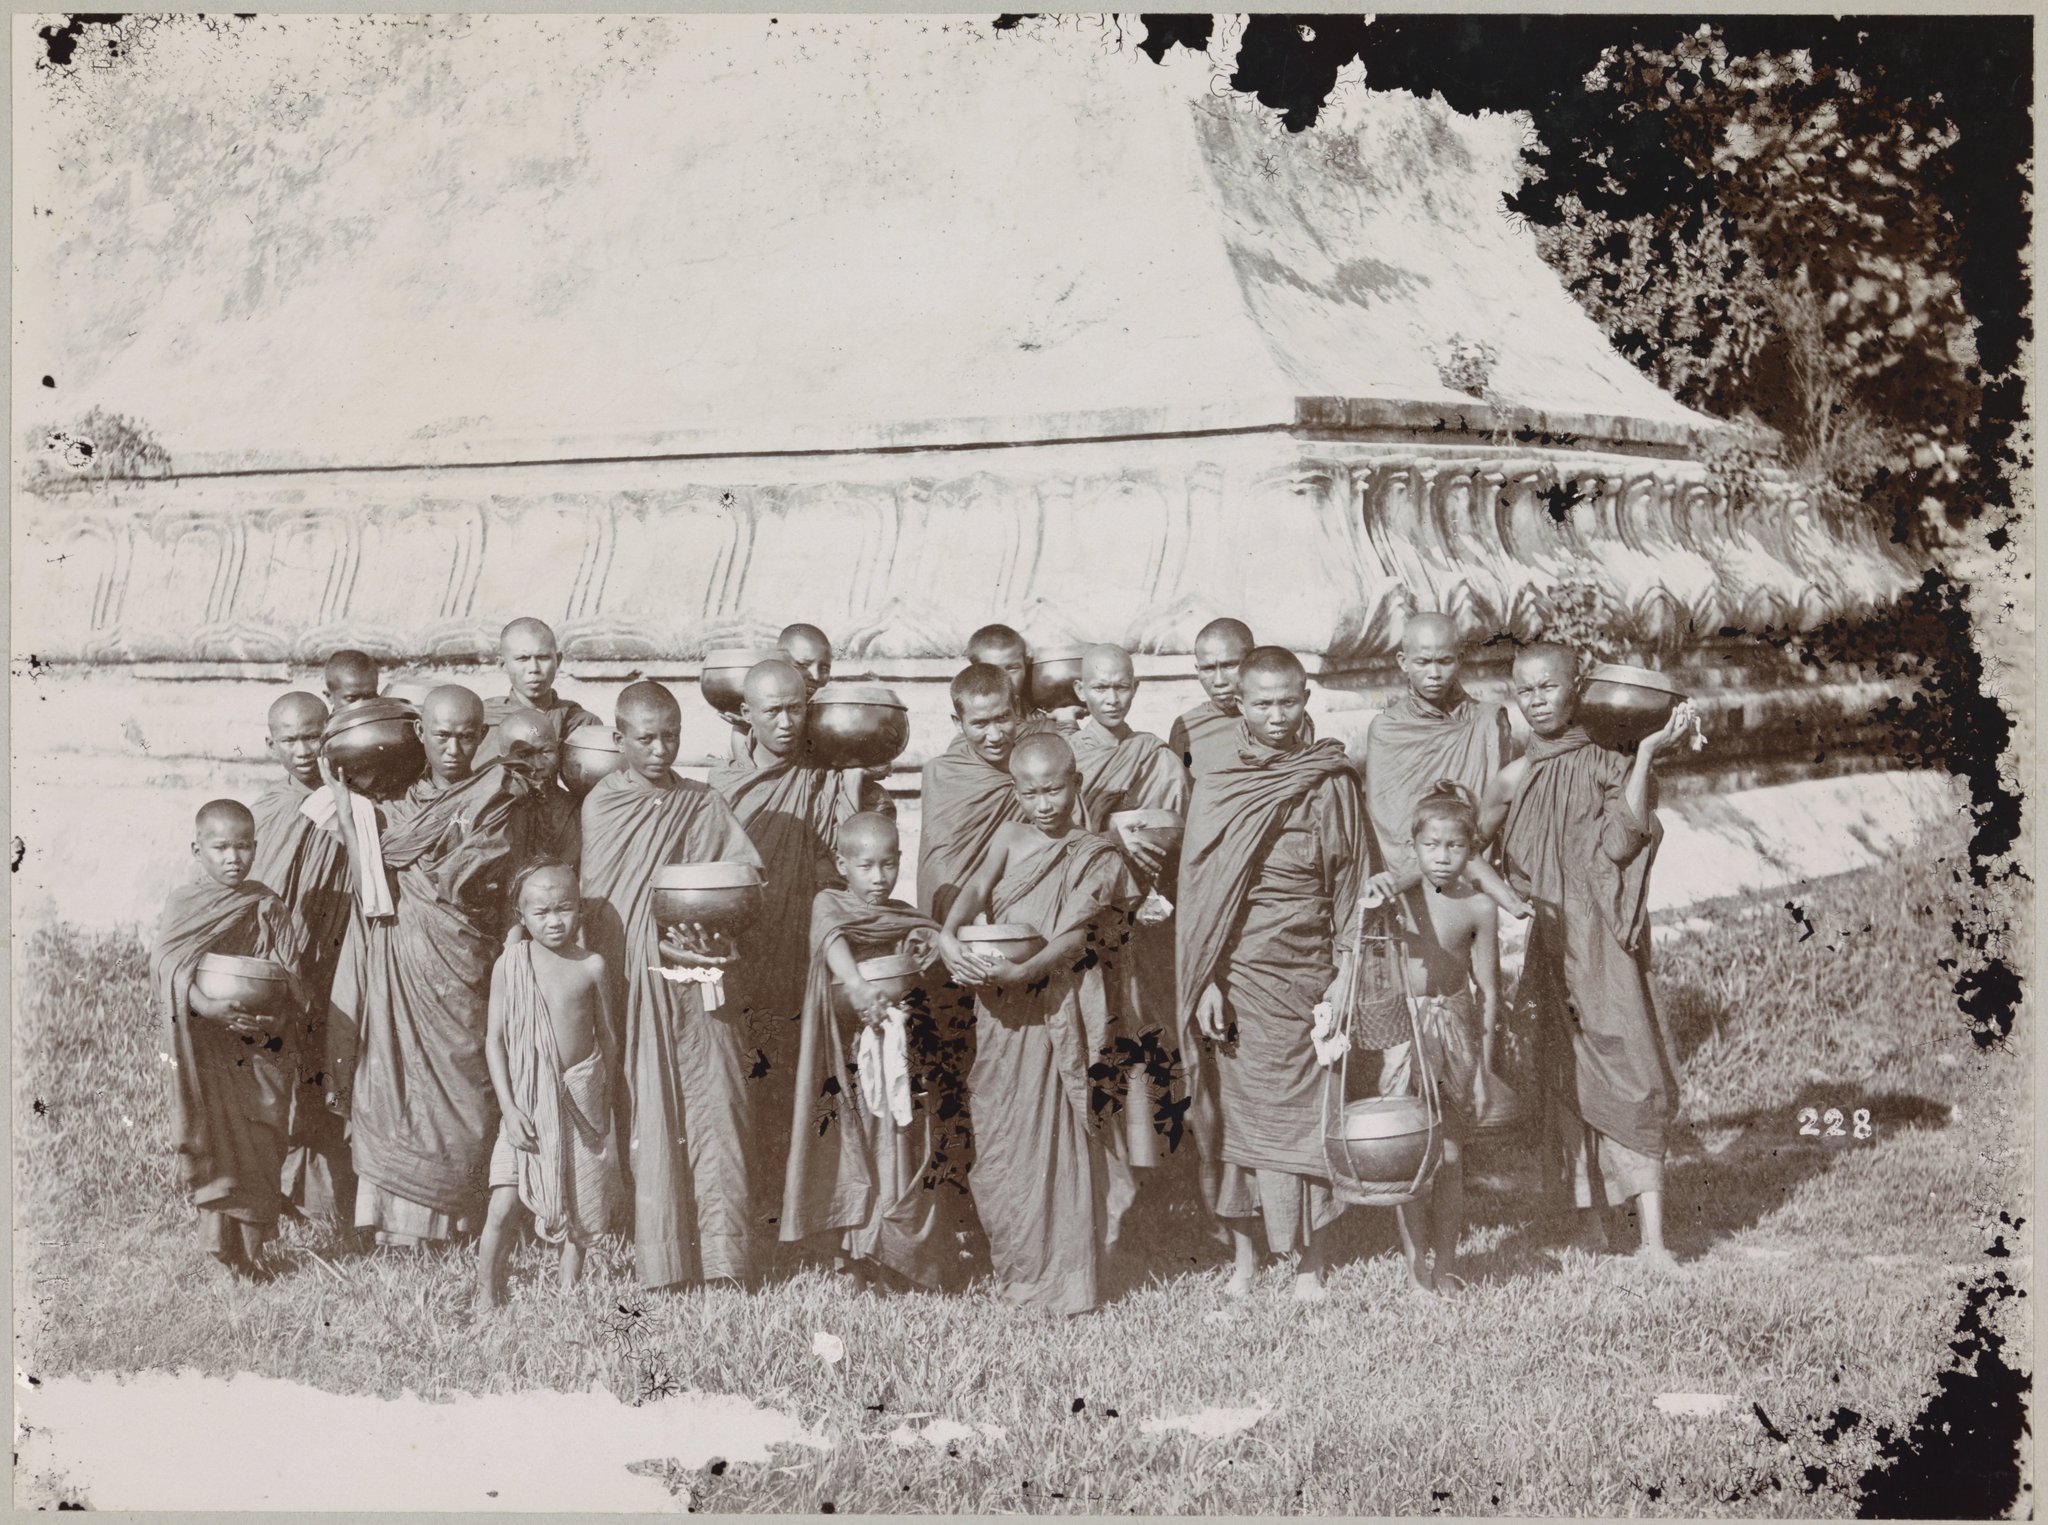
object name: photograph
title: Buddhist monks, Myanmar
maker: philip adolphe klier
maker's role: fotograaf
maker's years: 1845-1911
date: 1895-1915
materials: cardboard, paper, photographic support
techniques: collodion silver print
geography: myanmar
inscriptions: inscription: ‘11. priesters’, number: ‘228’